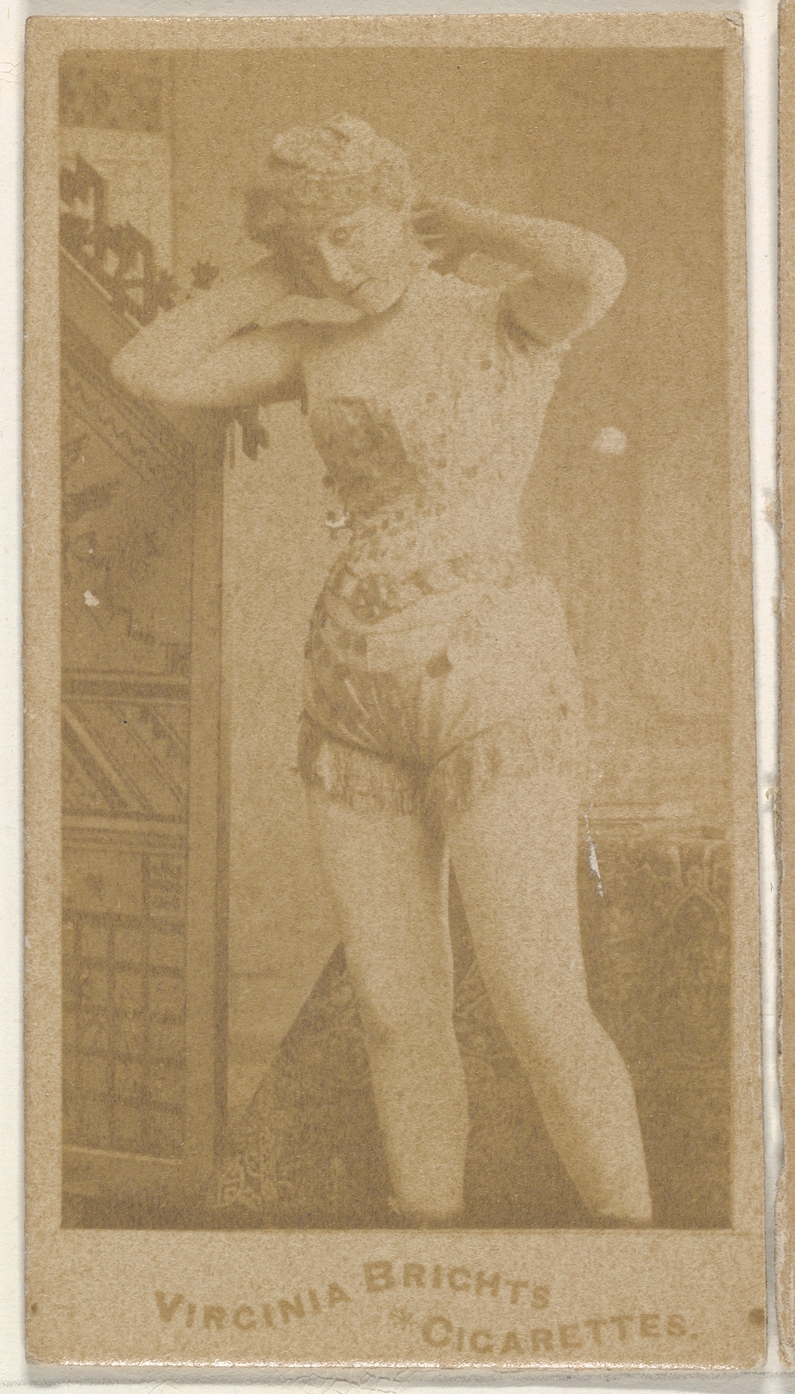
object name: photograph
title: From the Actors and Actresses series (N45, Type 5) for Virginia Brights Cigarettes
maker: allen & ginter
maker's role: publisher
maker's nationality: american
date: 1888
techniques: albumen silver print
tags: portraits,women